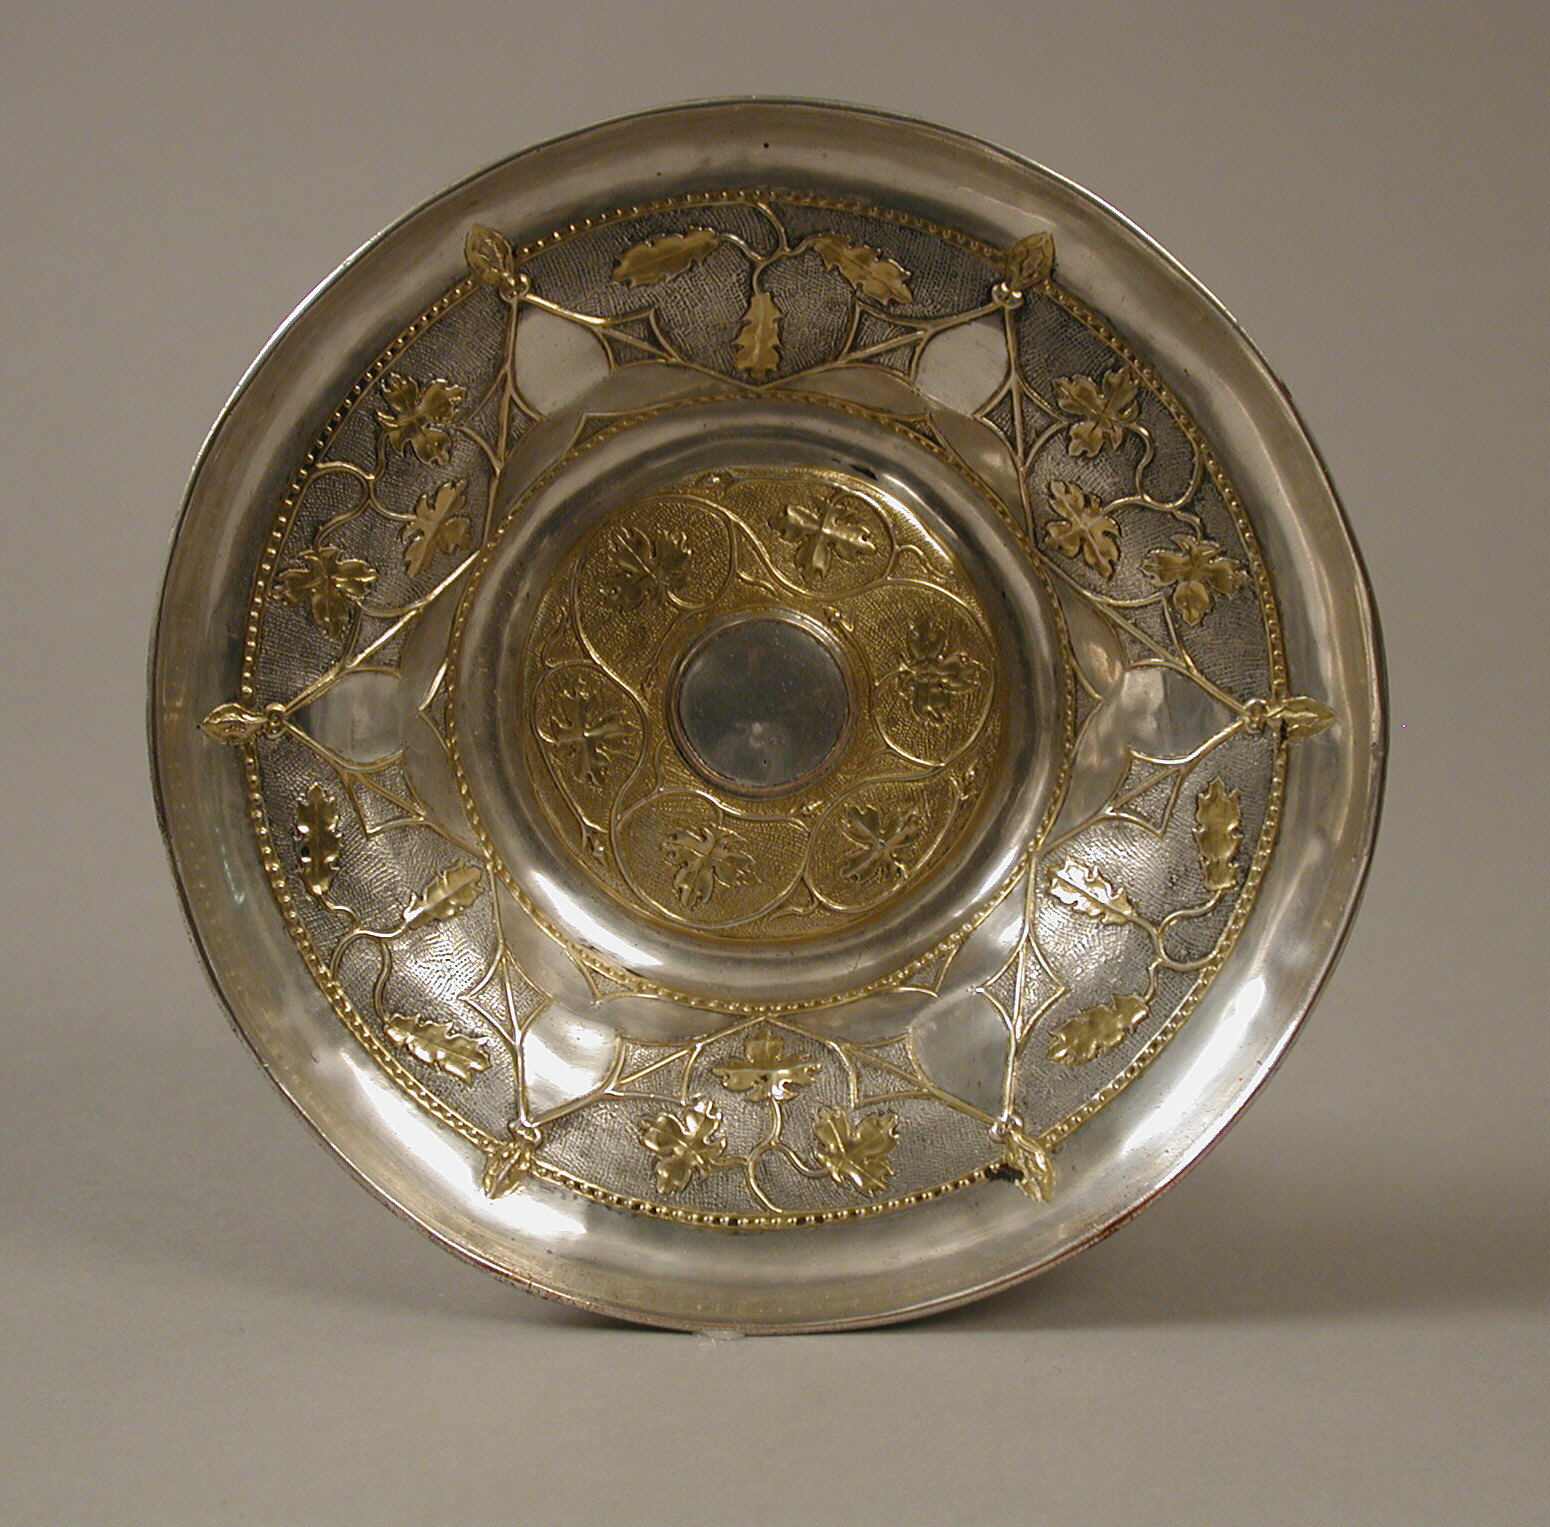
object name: bowl or plate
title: Bowl or Deep Plate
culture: french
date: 1801-1900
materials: silver